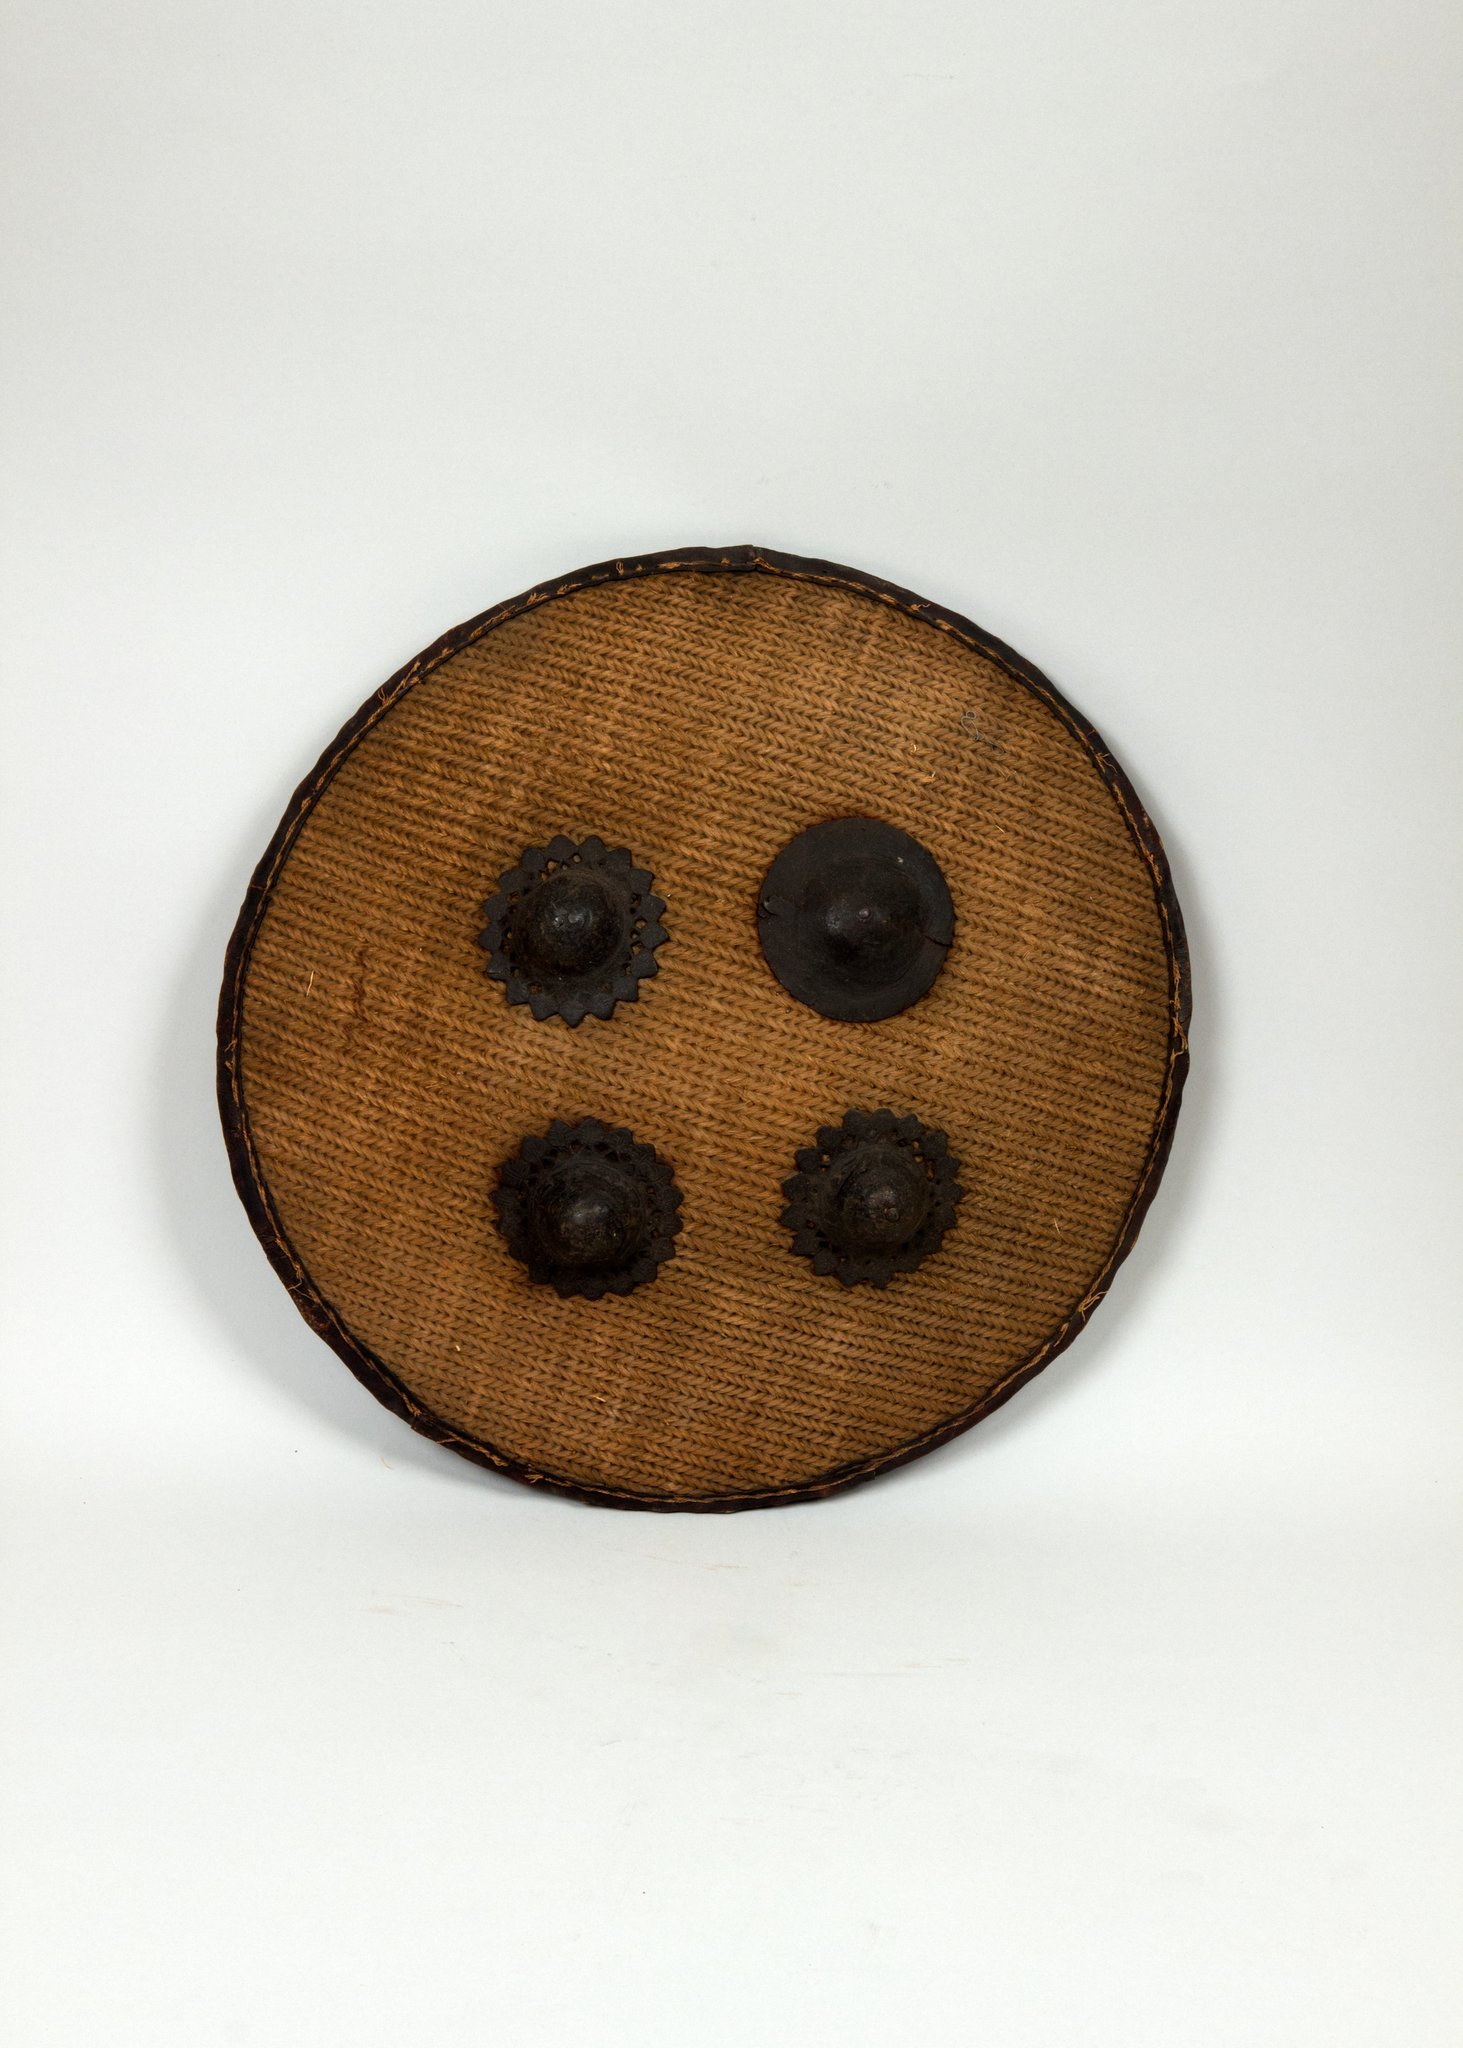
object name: shield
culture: afghan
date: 1801-1900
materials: cotton, iron, leather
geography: india